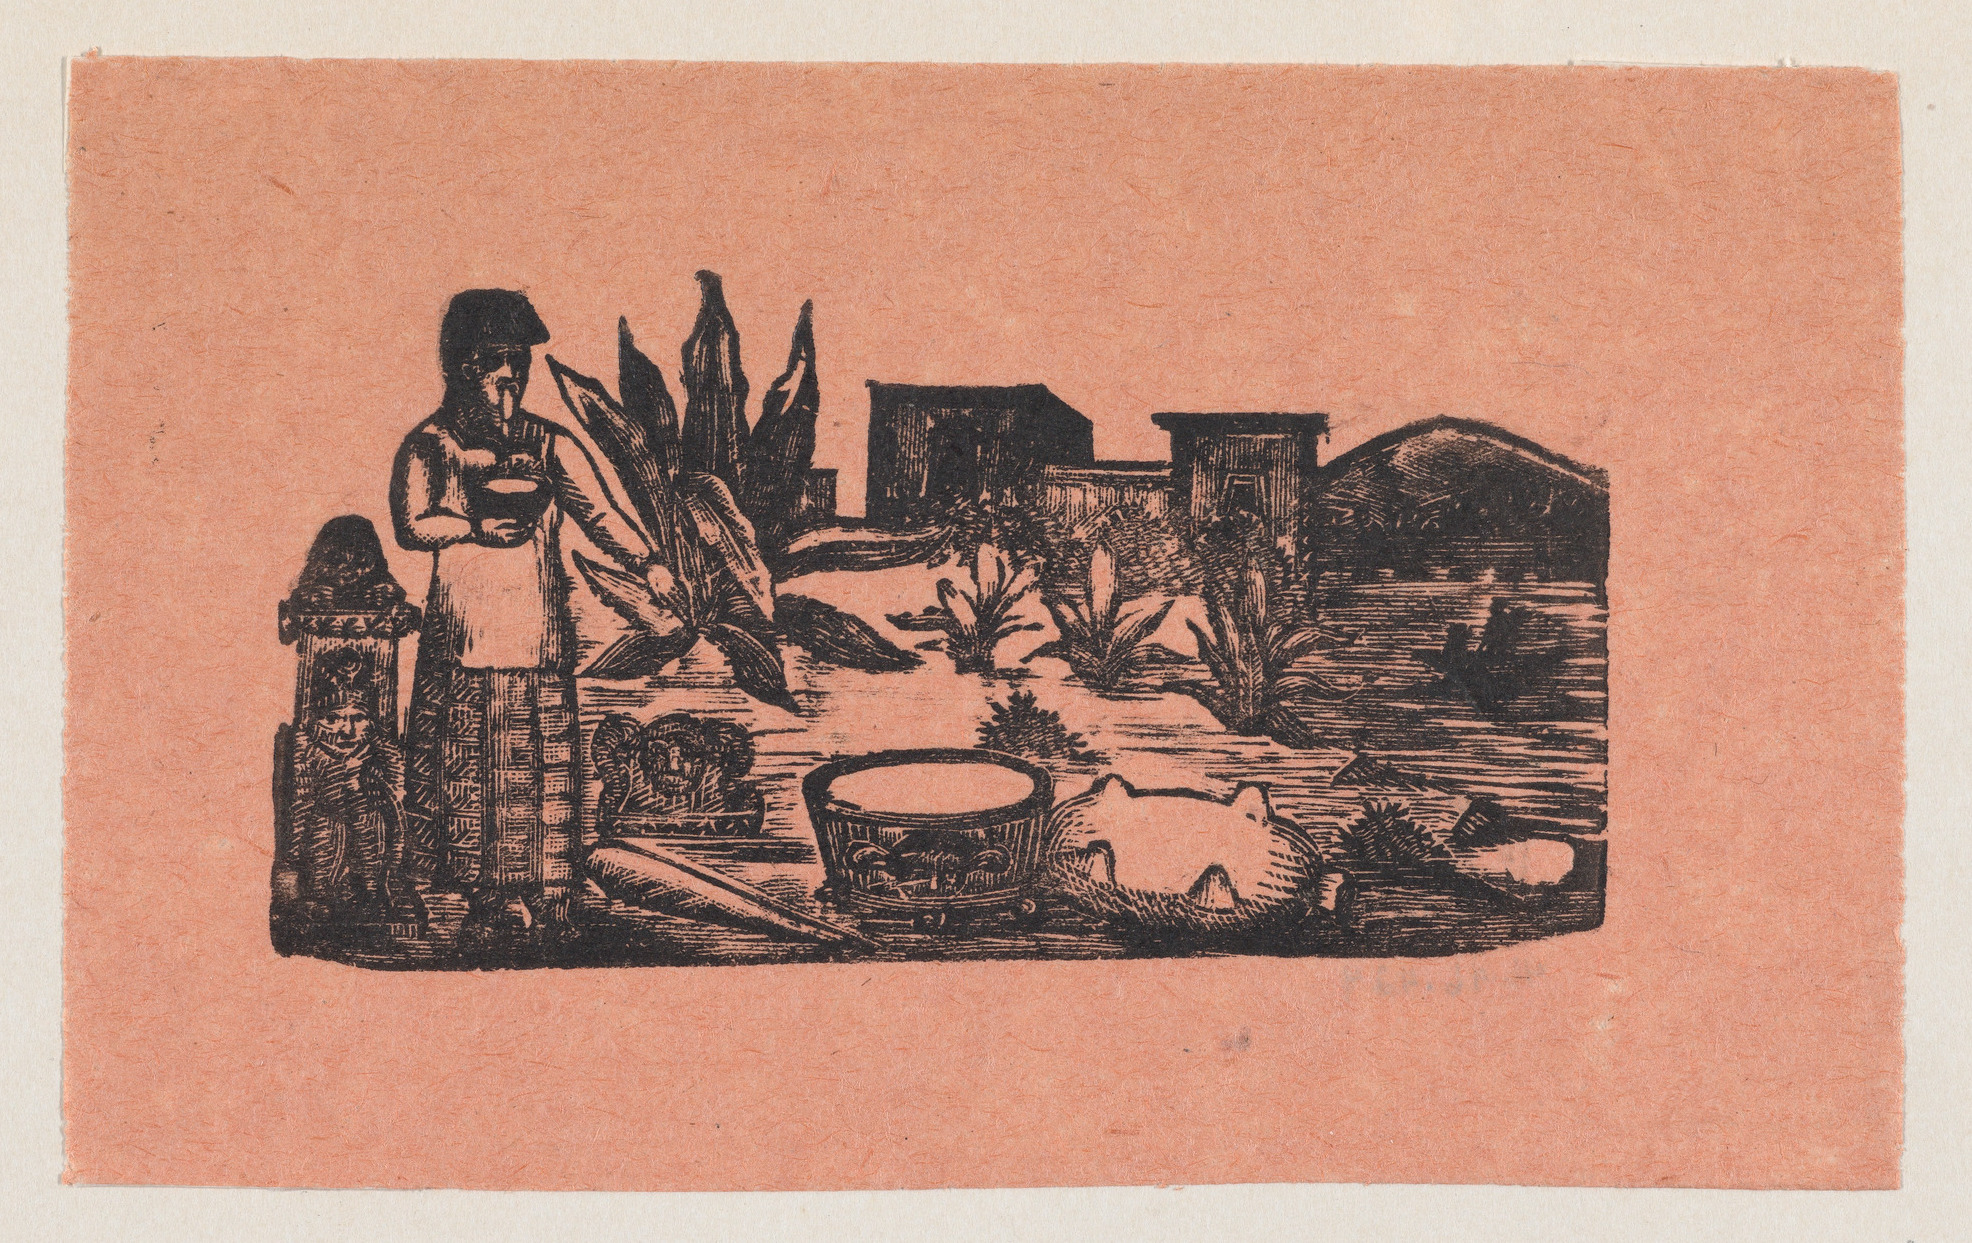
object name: print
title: A woman standing in the countryside pointing to a tub of water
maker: josé guadalupe posada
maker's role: artist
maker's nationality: mexican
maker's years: 1852-1913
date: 1890-1910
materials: metal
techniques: engraving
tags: women